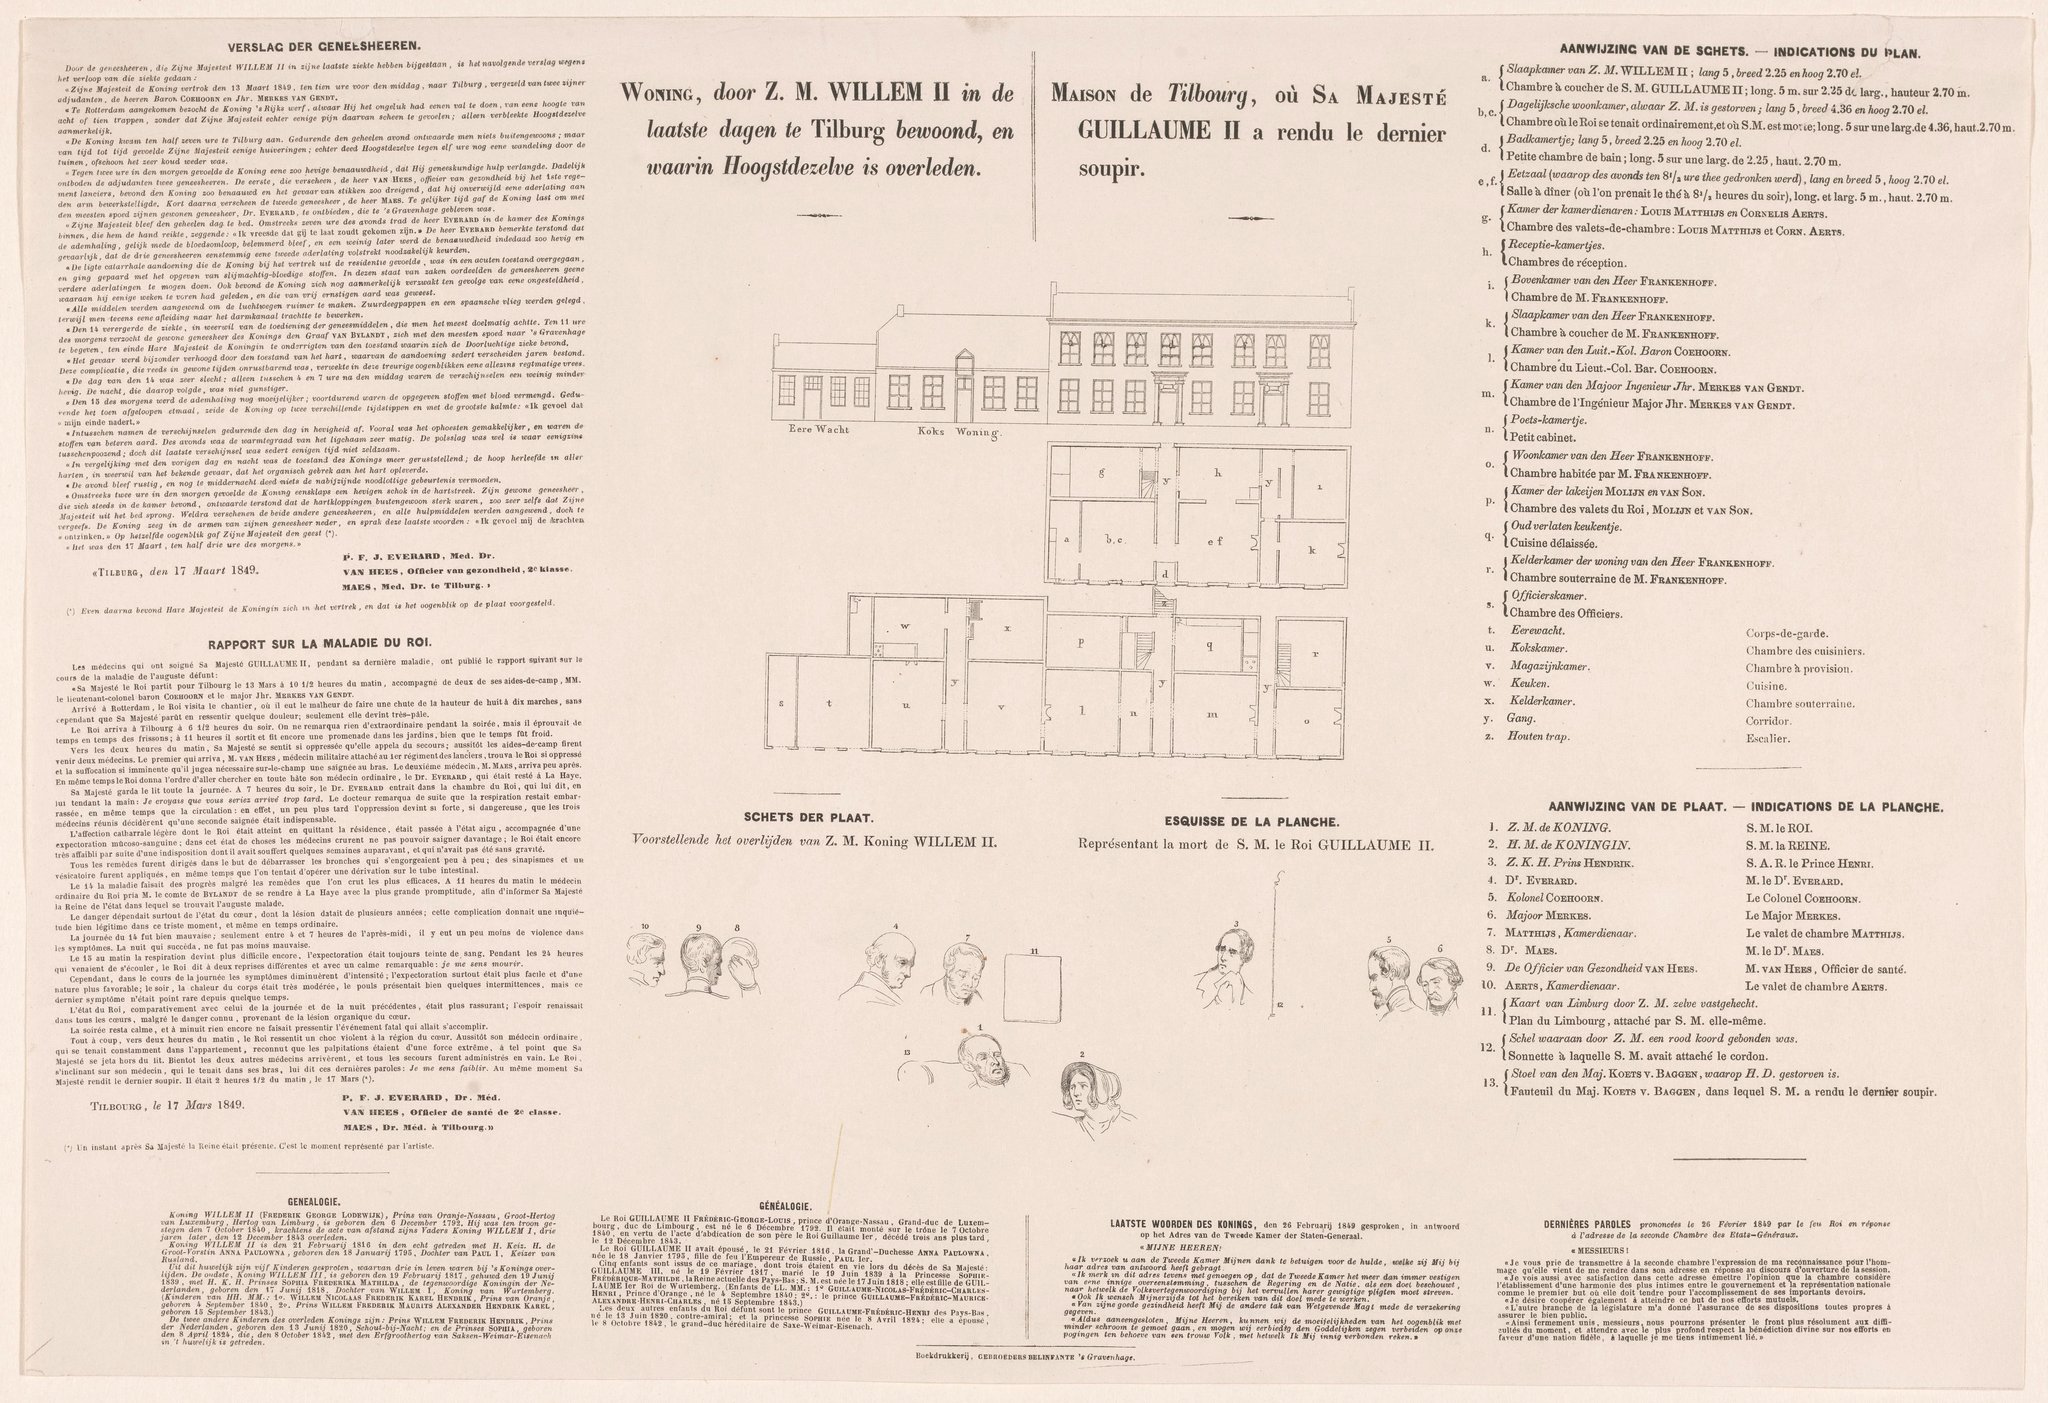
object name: print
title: Verklaring bij de prent van het overlijden van koning Willem II, 1849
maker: Anonymous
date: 1849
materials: paper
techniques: lithograph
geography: the hague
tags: the hague, william ii of the netherlands, deathbed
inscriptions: collector's mark: Lugt 2228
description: Aparte verklaring behorende bij de prent van het overlijden van koning Willem II in Tilburg op 17 maart 1849. Centraal een plattegrond van de woning van de koning te Tilburg, daaronder een sleutel met de namen van de voorgestelde personen. Links, rechts en onderaan het verslag van de artsen, de genealogie en de laatste woorden van de koning en de legenda's a-z en 1-13.